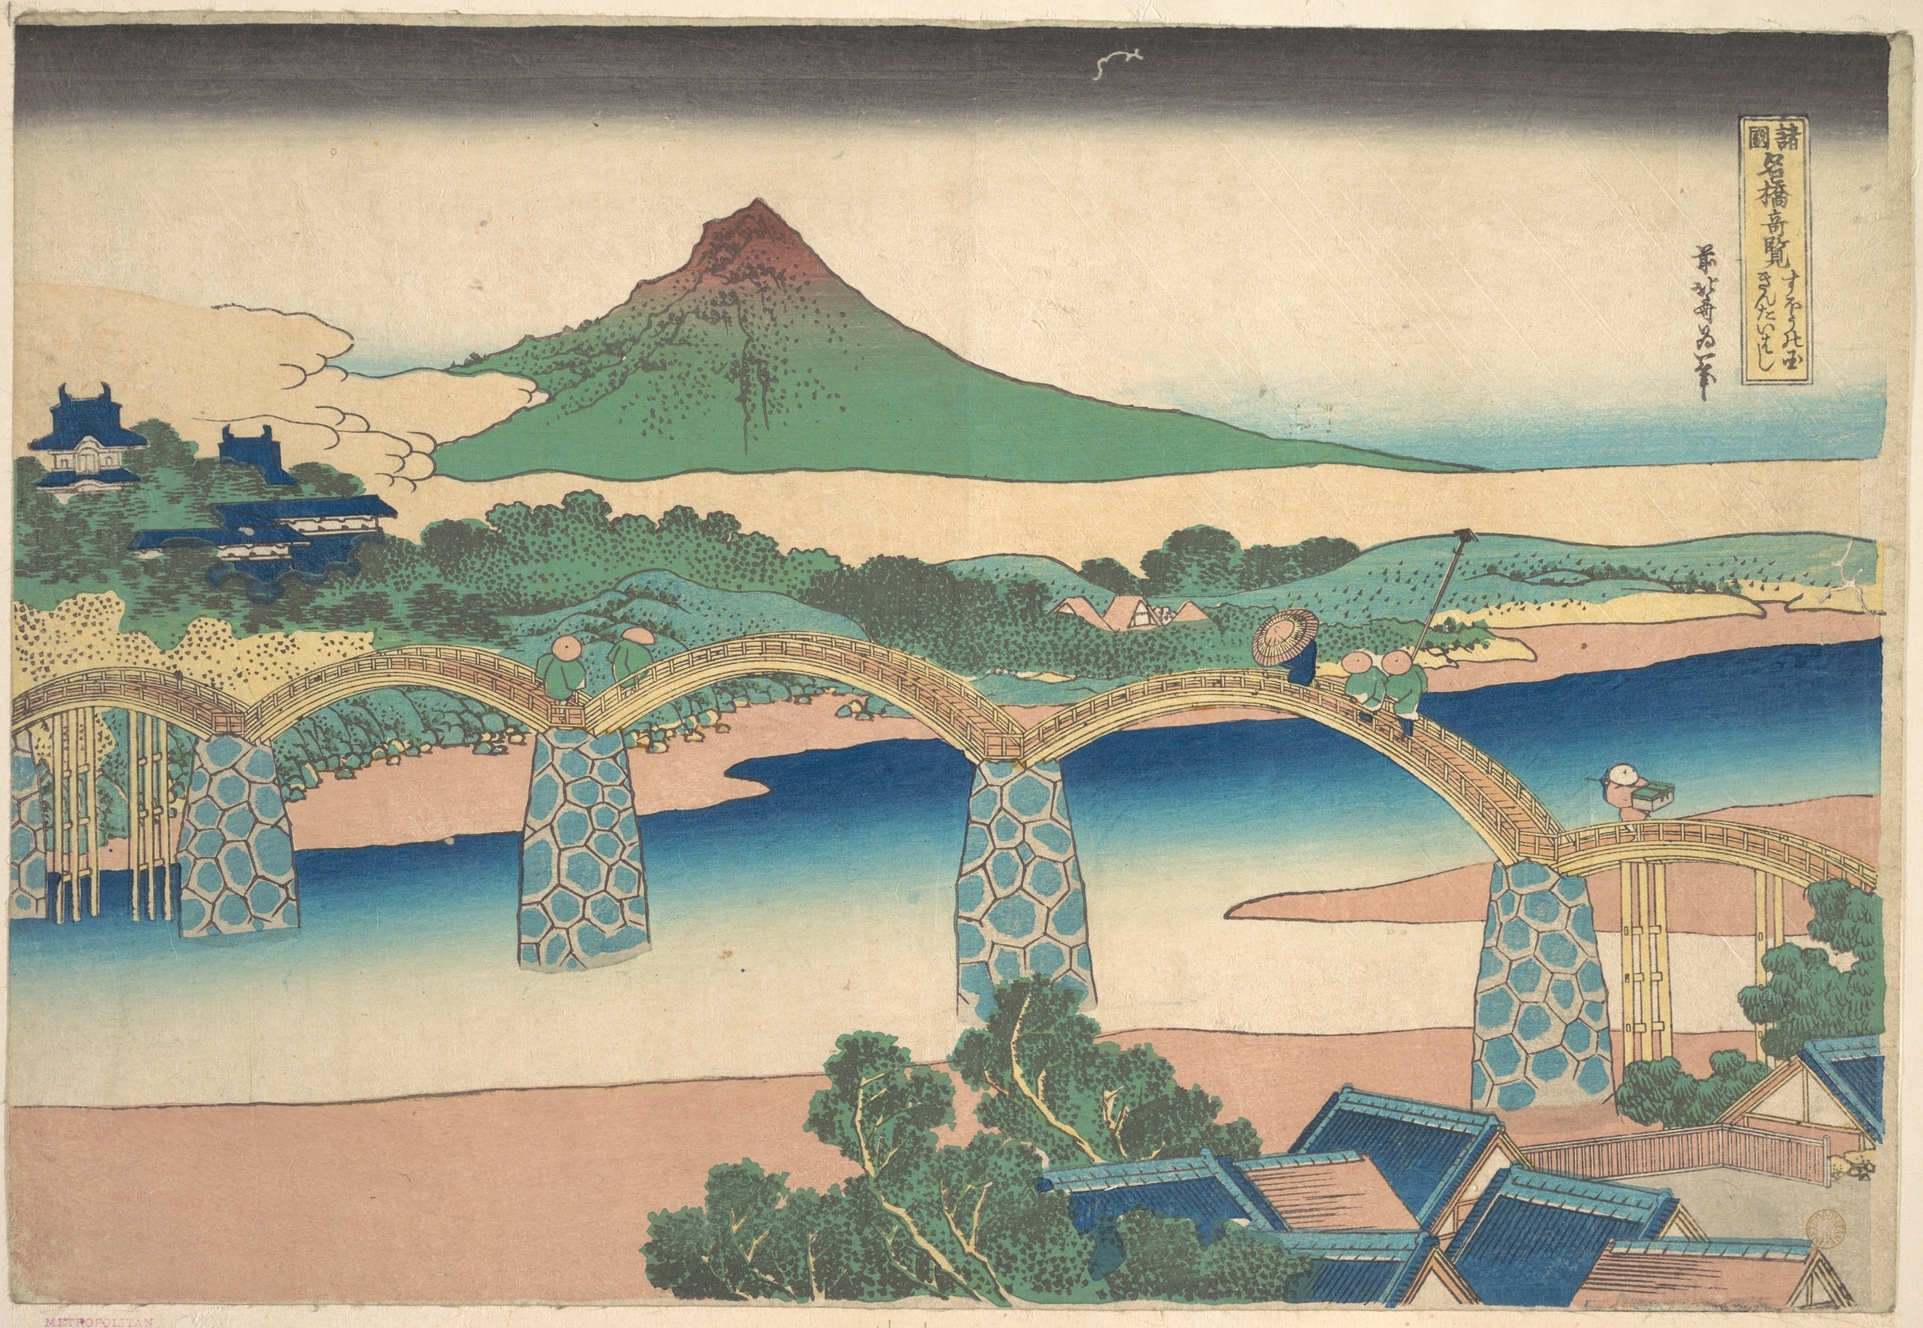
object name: print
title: Kintai Bridge in Suō Province (Suō no kuni Kintaibashi), from the series Remarkable Views of Bridges in Various Provinces (Shokoku meikyō kiran)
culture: japanese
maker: katsushika hokusai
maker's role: artist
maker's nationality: japanese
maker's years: 1760-1849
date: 1827-1830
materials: ink, paper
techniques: woodblock print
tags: bridges,landscapes